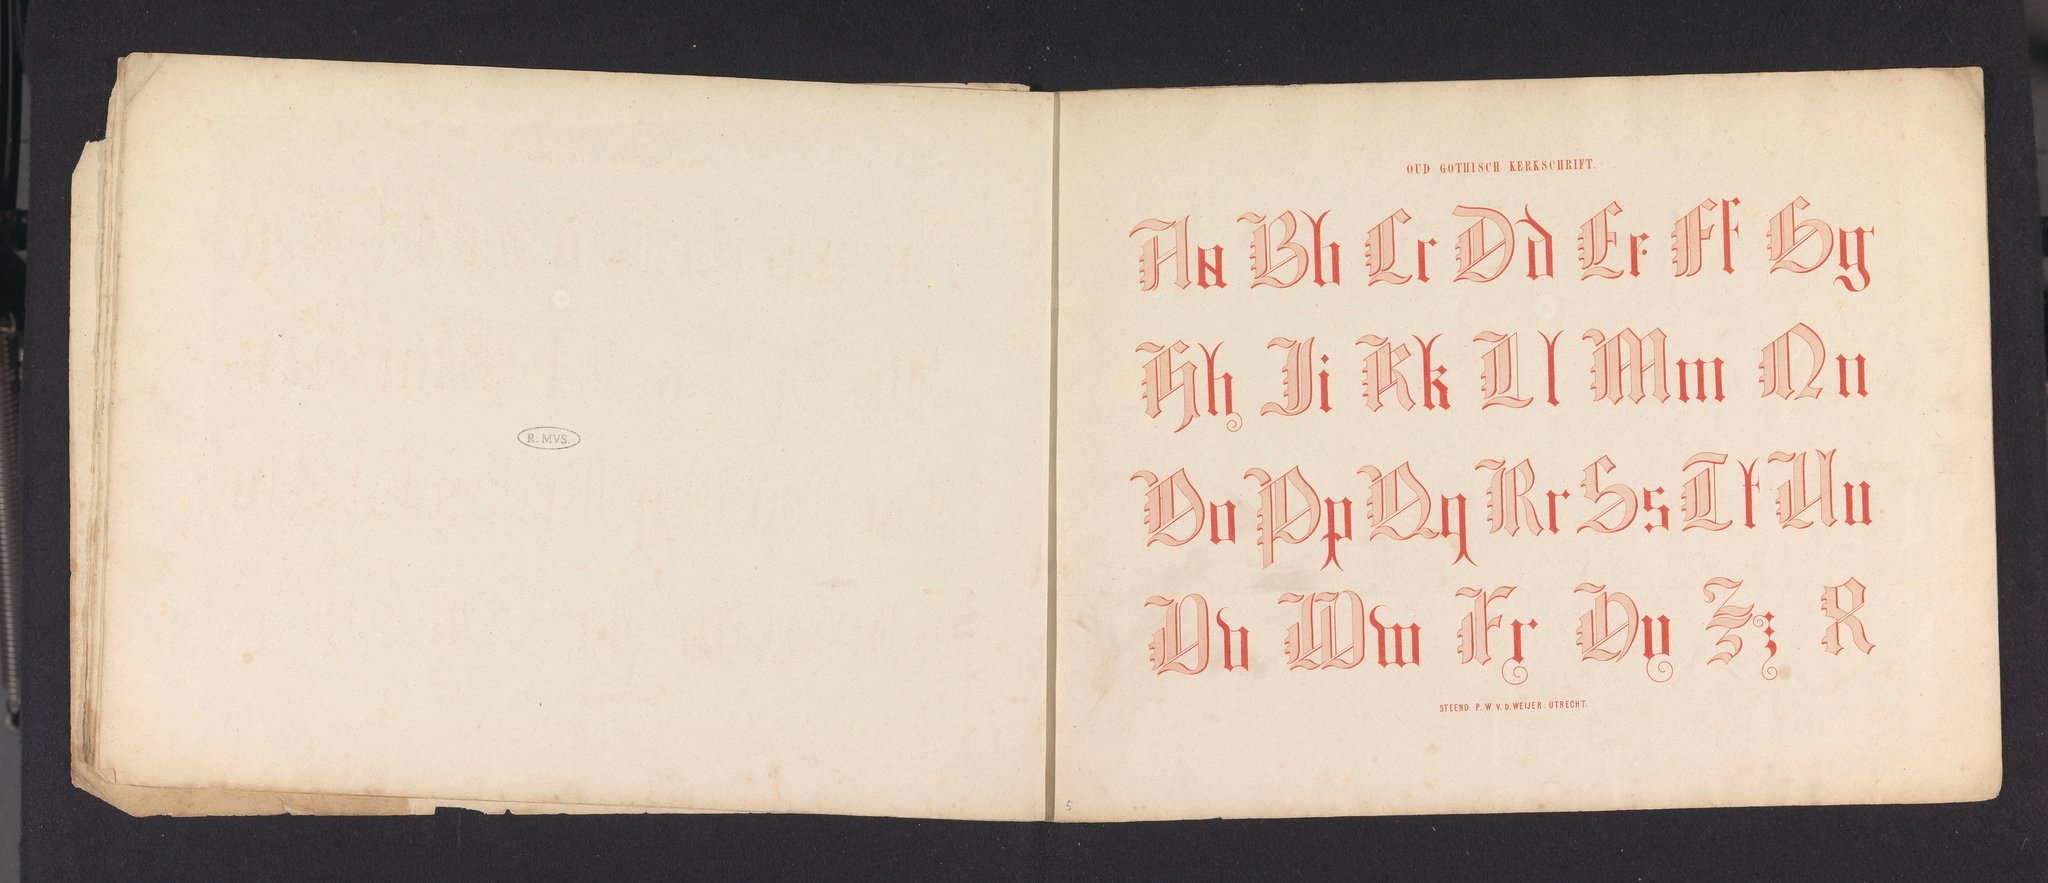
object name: album leaf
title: Alfabet in Gotiek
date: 1855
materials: paper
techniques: lithograph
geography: utrecht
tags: letters, alphabet, script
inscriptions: collector's mark: Lugt 2228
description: De prent maakt onderdeel uit van een album.